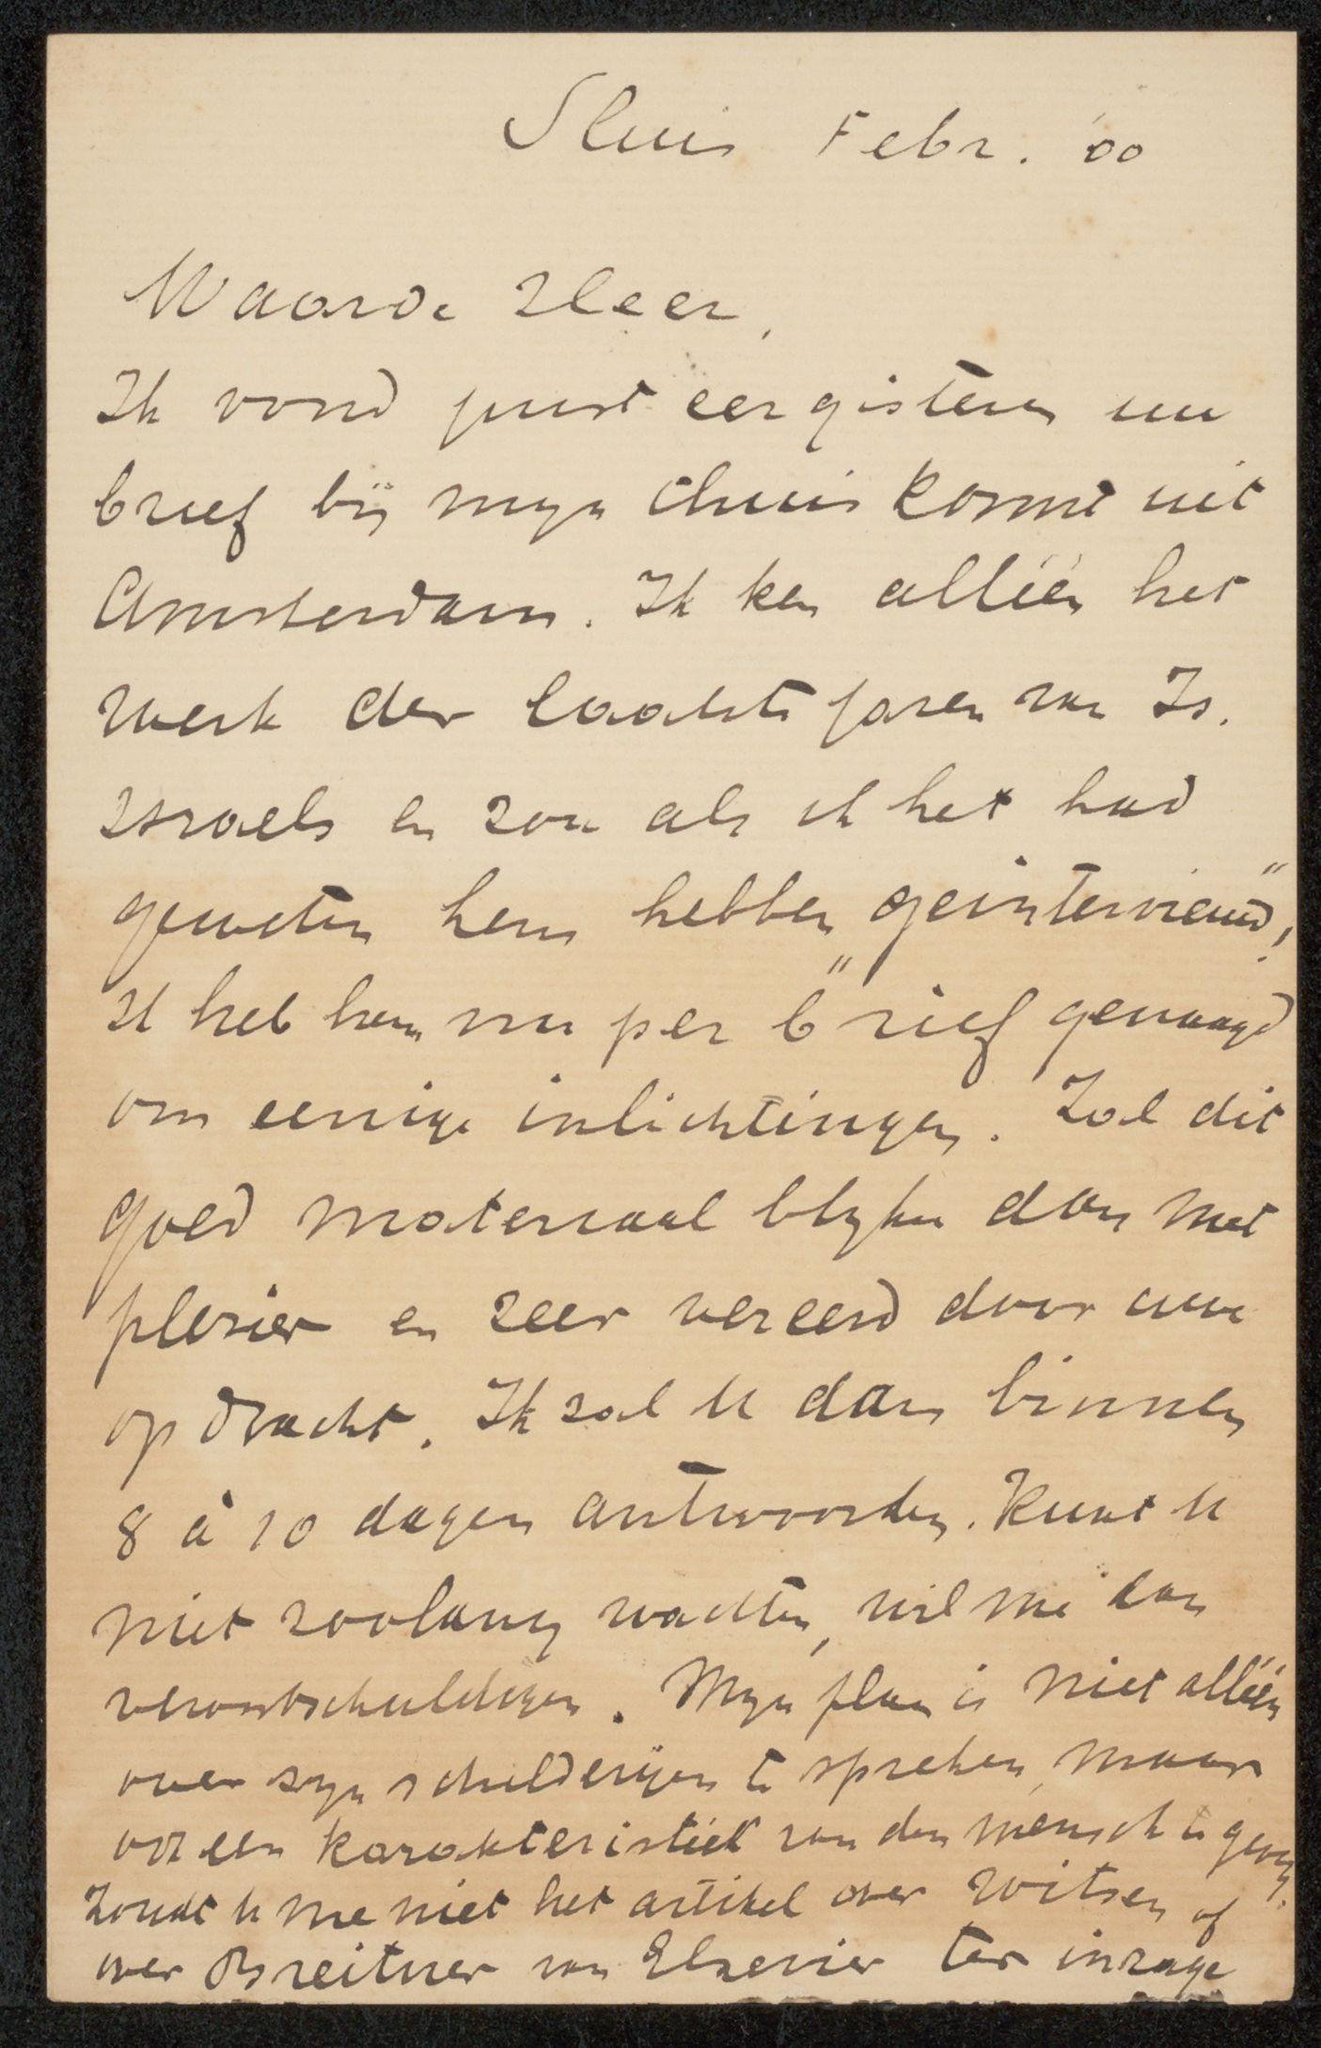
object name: letter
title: Brief aan Philip Zilcken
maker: frans erens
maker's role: criticus, prozaschrijver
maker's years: 1857-1935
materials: ink, paper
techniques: pen, writing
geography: sluis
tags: the hague, print maker, draughtsman, isaac israels, philip zilcken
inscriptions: collector's mark: ‘RPK’